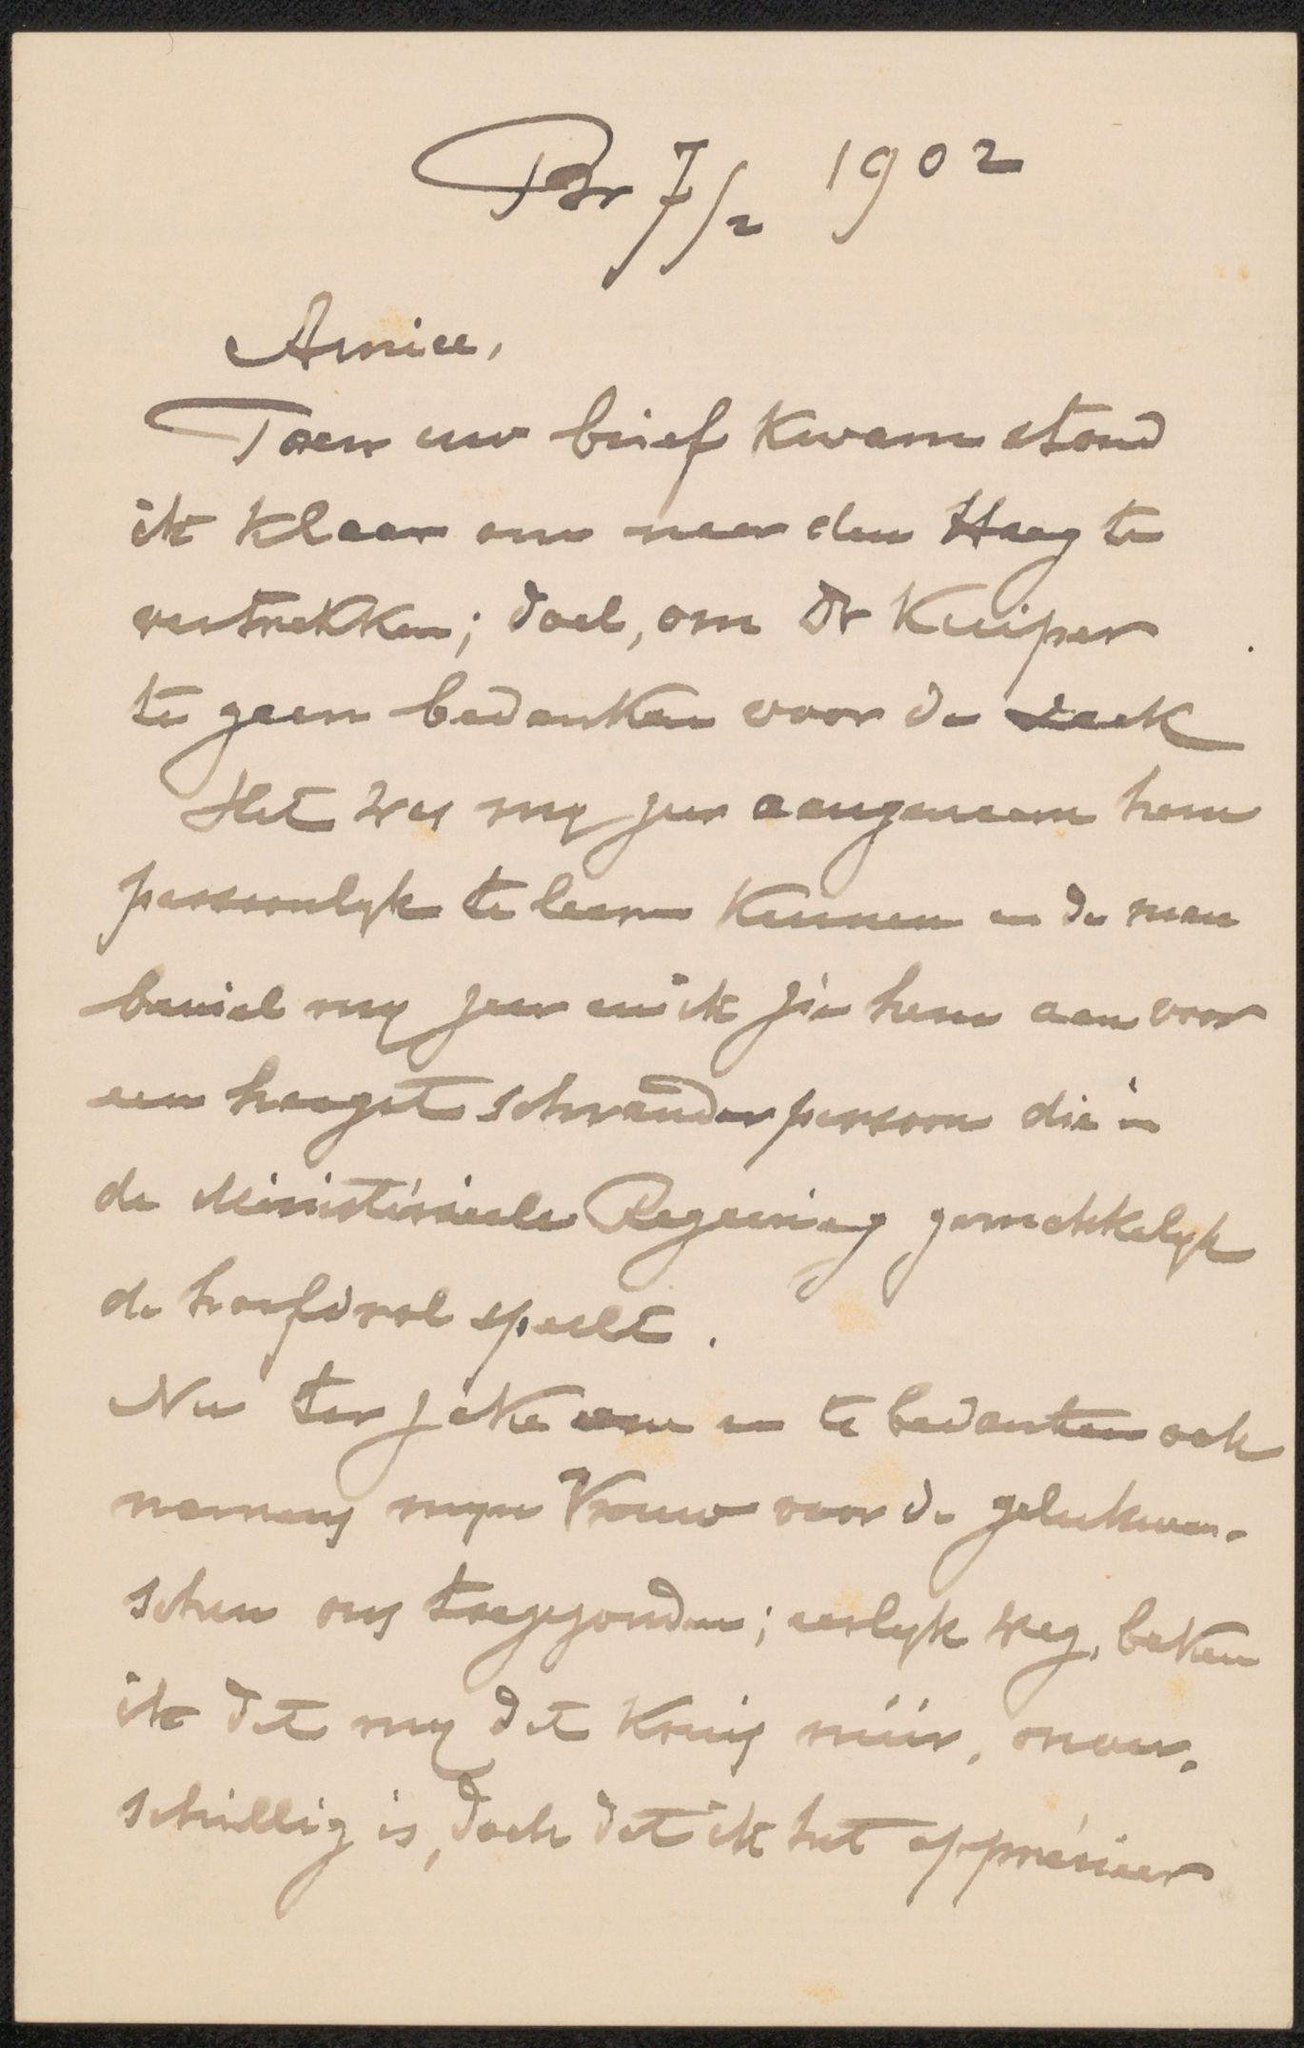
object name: letter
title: Brief aan August Allebé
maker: johannes hubertus leonardus de haas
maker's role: draughtsman, painter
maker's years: 1832-1908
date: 1902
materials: ink, paper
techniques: pen, writing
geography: brussels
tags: august allebé, amsterdam, print maker, draughtsman, paul joseph constantin gabriël, the hague, abraham kuyper, diseases